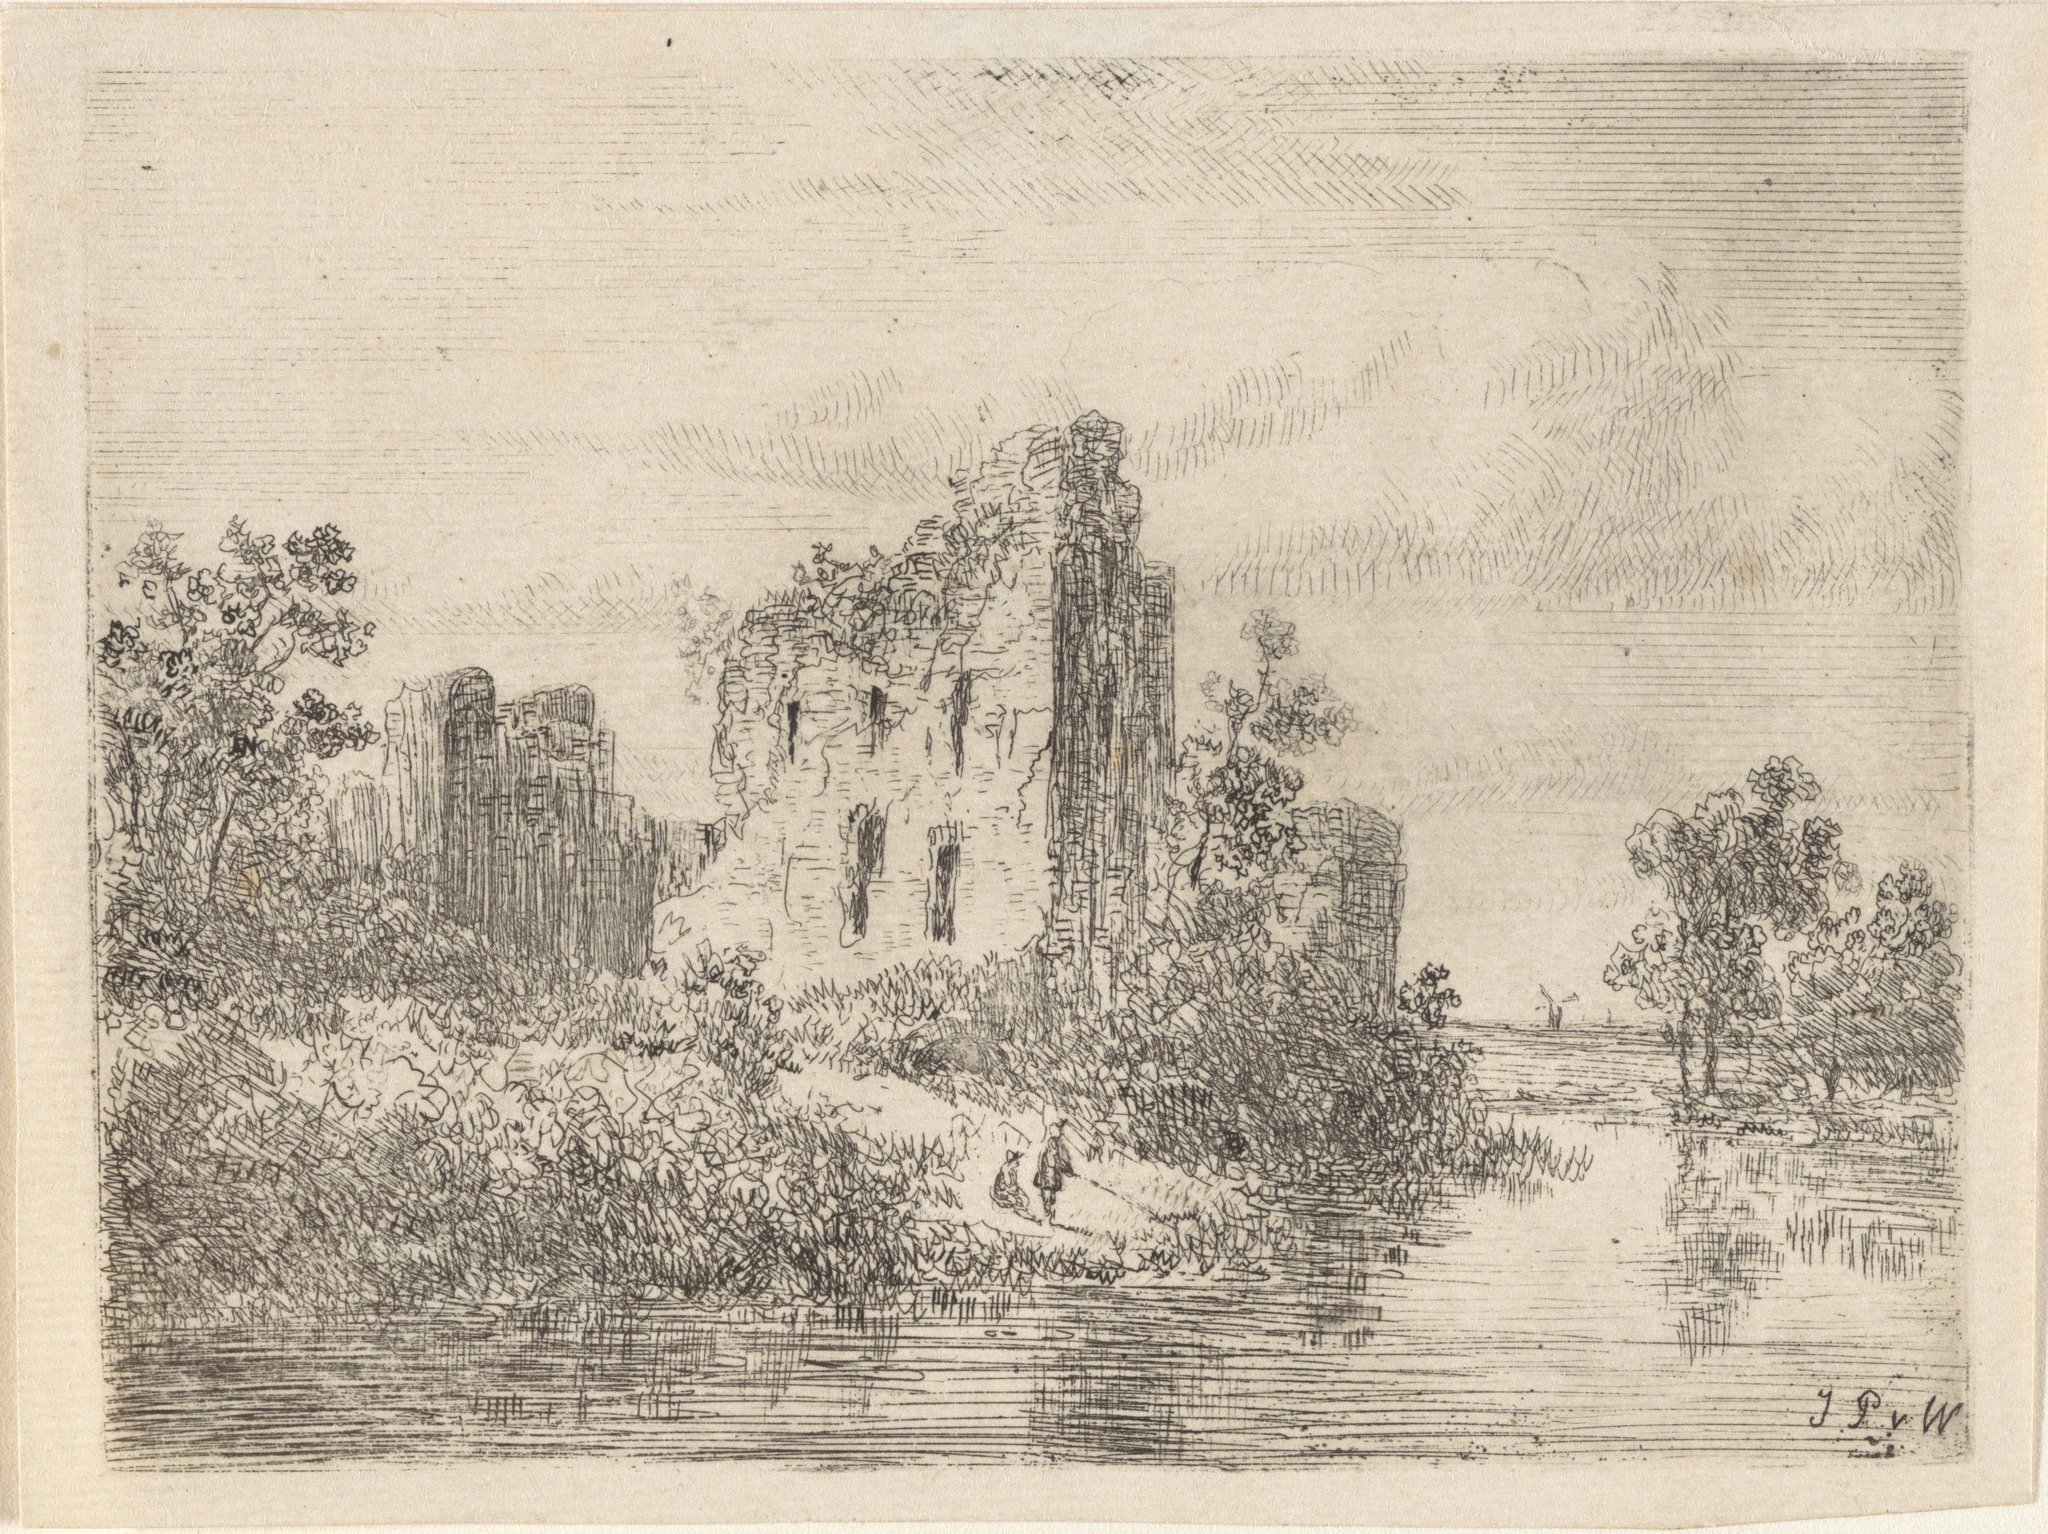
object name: print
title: Ruïne aan een rivier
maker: johannes pieter van wisselingh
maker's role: draughtsman, painter, print maker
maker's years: 1812-1899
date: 1830-1878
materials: paper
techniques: etching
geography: netherlands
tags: river, landscape with ruins, angling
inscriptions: collector's mark: Lugt 2228, name: ‘Wesseling’, collector's mark: Lugt 1485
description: Links een ruïne aan een rivier. Op de oever bij de ruïne twee vissers. In de verte een molen.